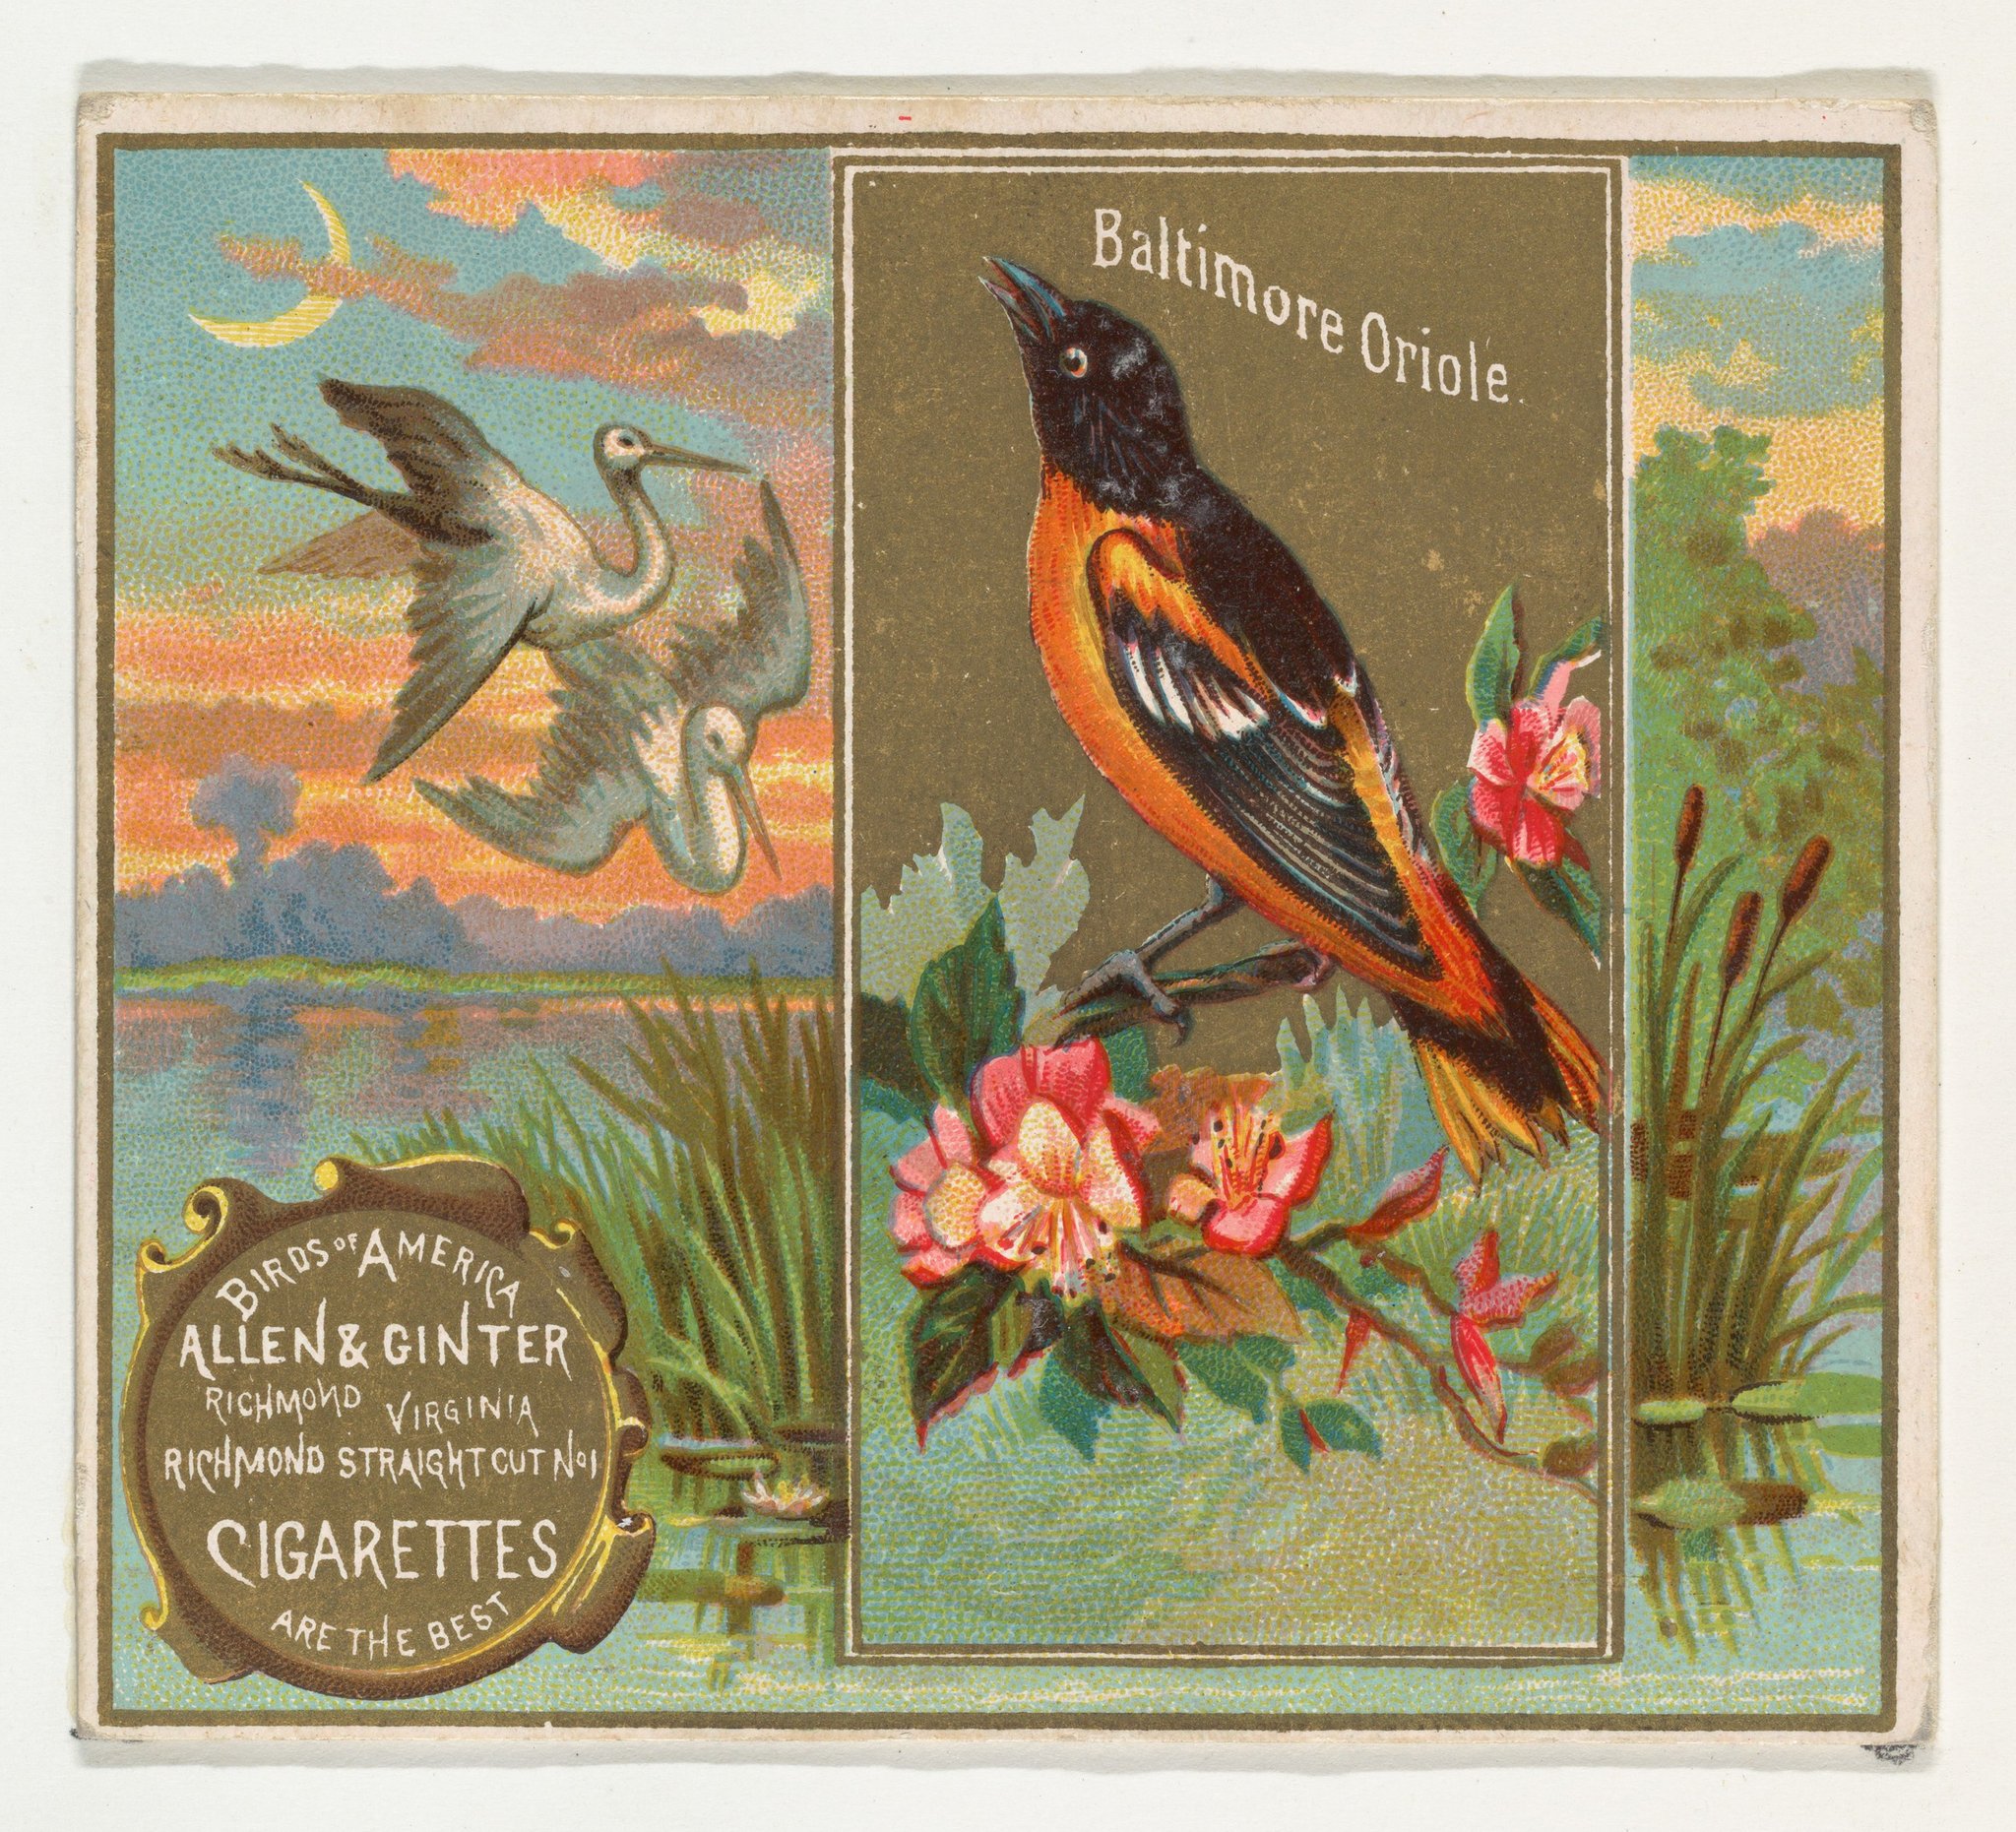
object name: print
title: Baltimore Oriole, from the Birds of America series (N37) for Allen & Ginter Cigarettes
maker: allen & ginter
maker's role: publisher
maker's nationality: american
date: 1888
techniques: color lithograph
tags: birds